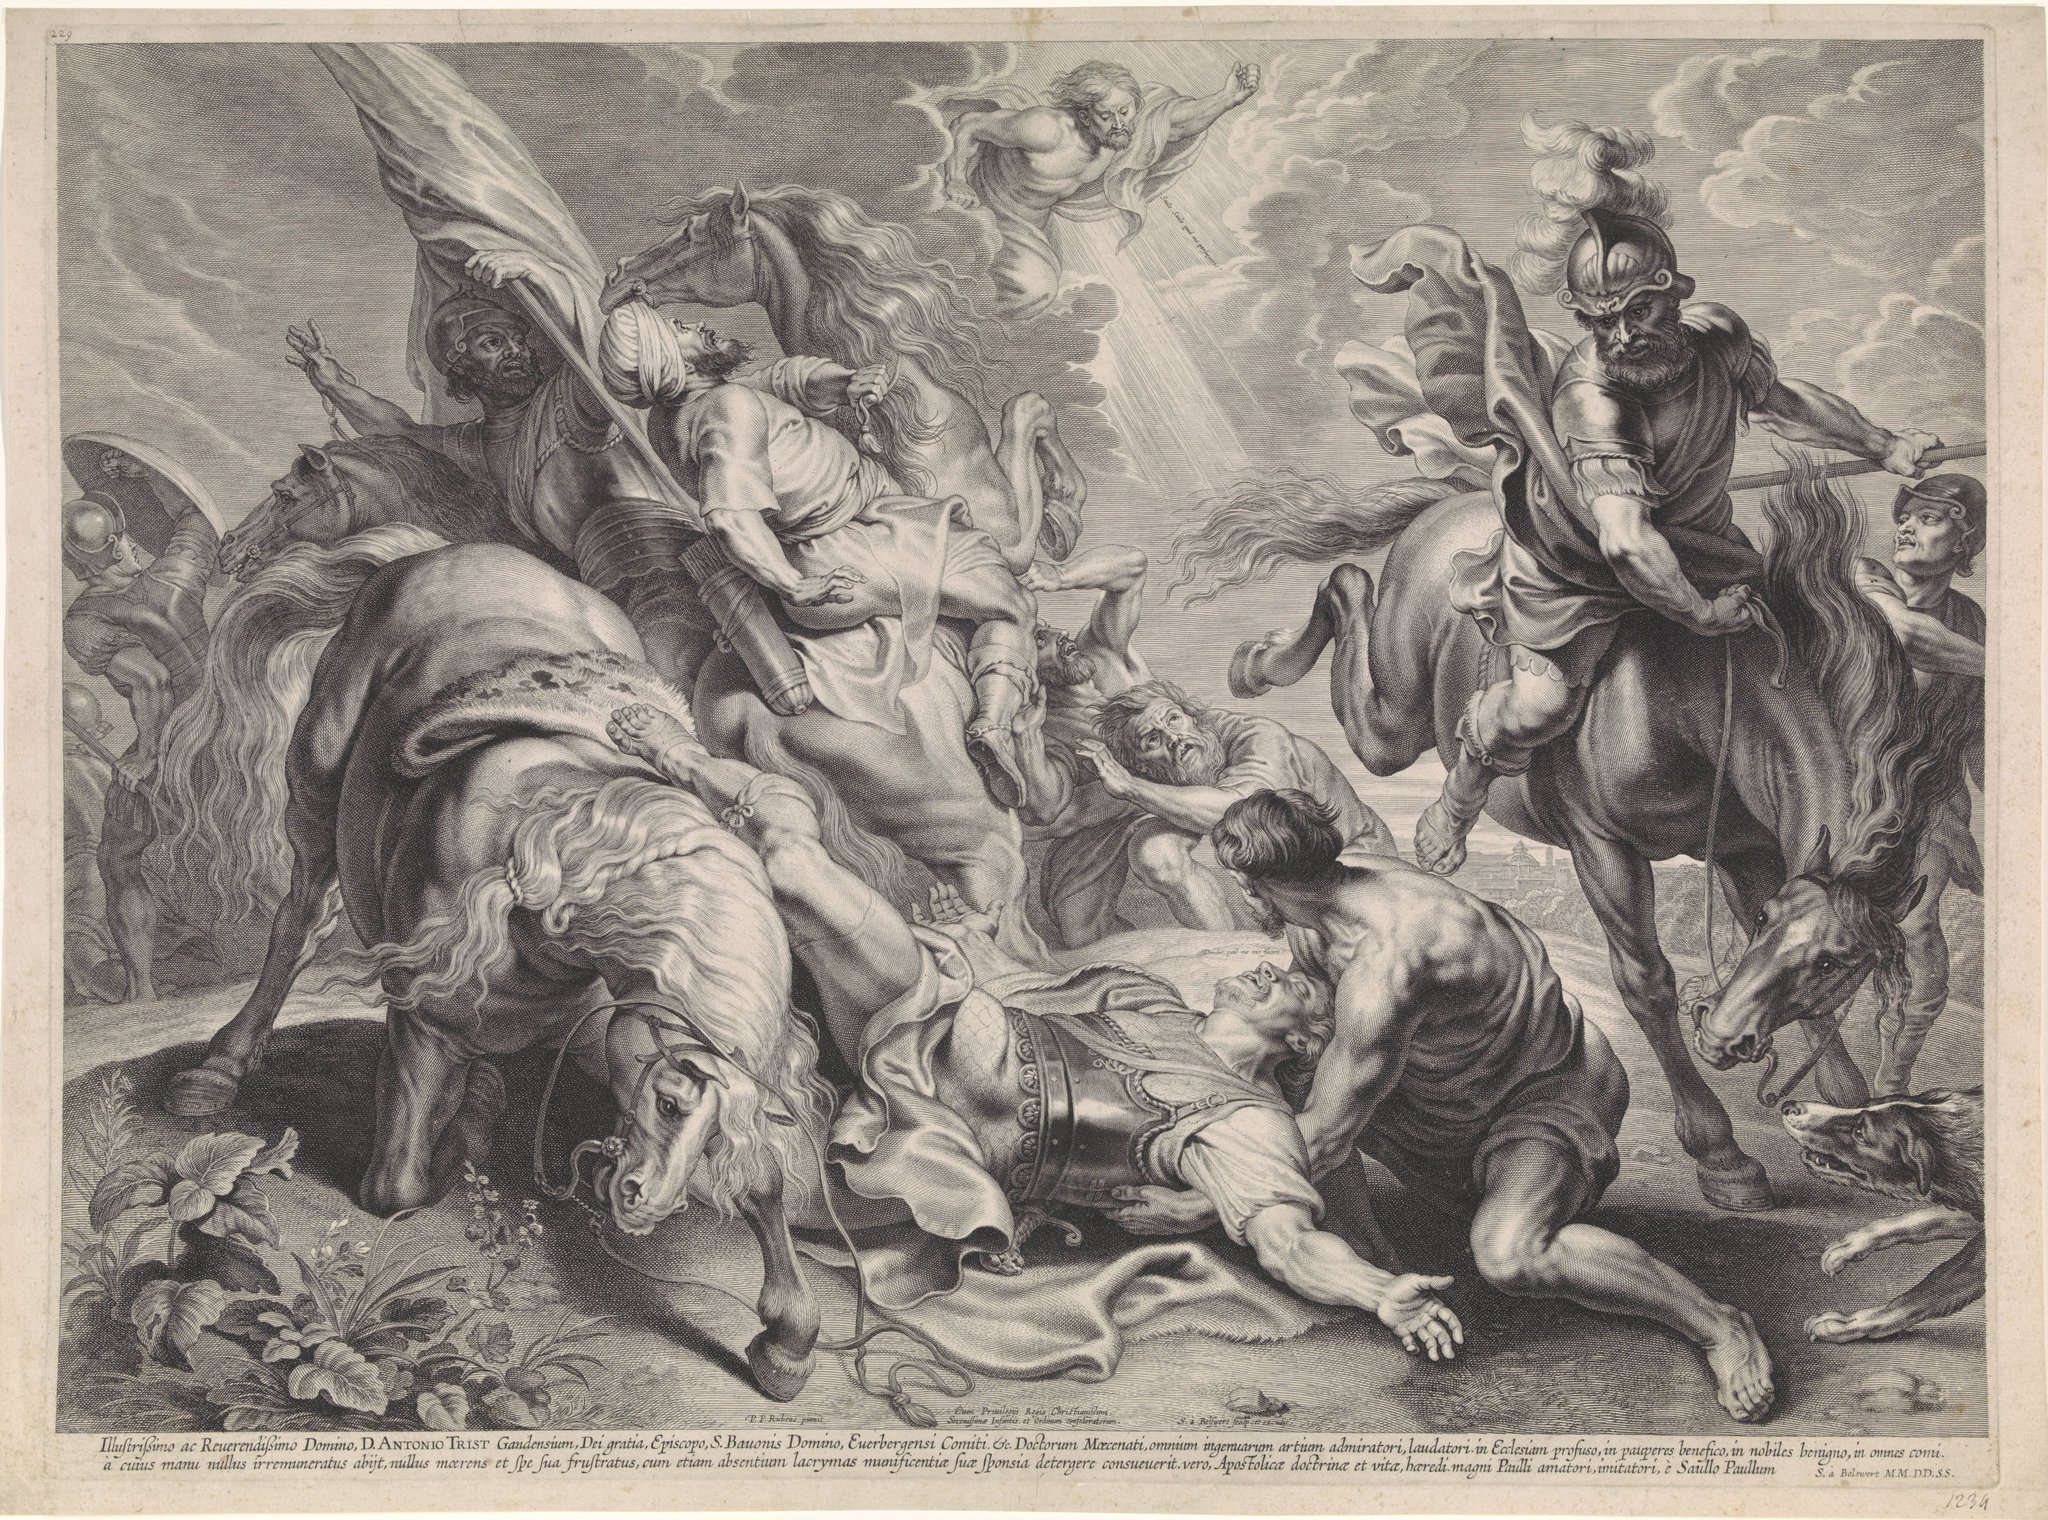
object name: print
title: Bekering van Paulus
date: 1596-1659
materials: paper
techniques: engraving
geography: netherlands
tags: saul desires letters from the high priest so as to persecute the disciples of the lord in damascus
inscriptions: collector's mark: Lugt 240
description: Paulus valt van zijn paard als hij wordt verblind bij de verschijning van Christus op de weg naar Damascus. Deze gebeurtenis gaf voor Paulus aanleiding tot zijn bekering.